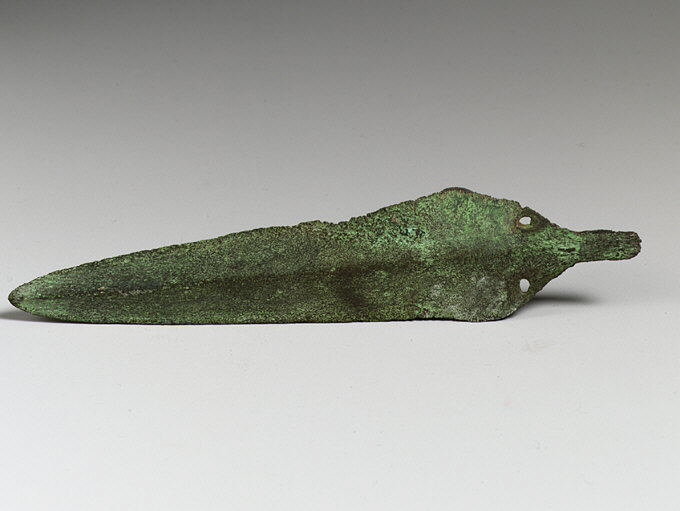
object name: dagger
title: Copper alloy dagger blade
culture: cypriot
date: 2200-1800 BCE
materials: bronze